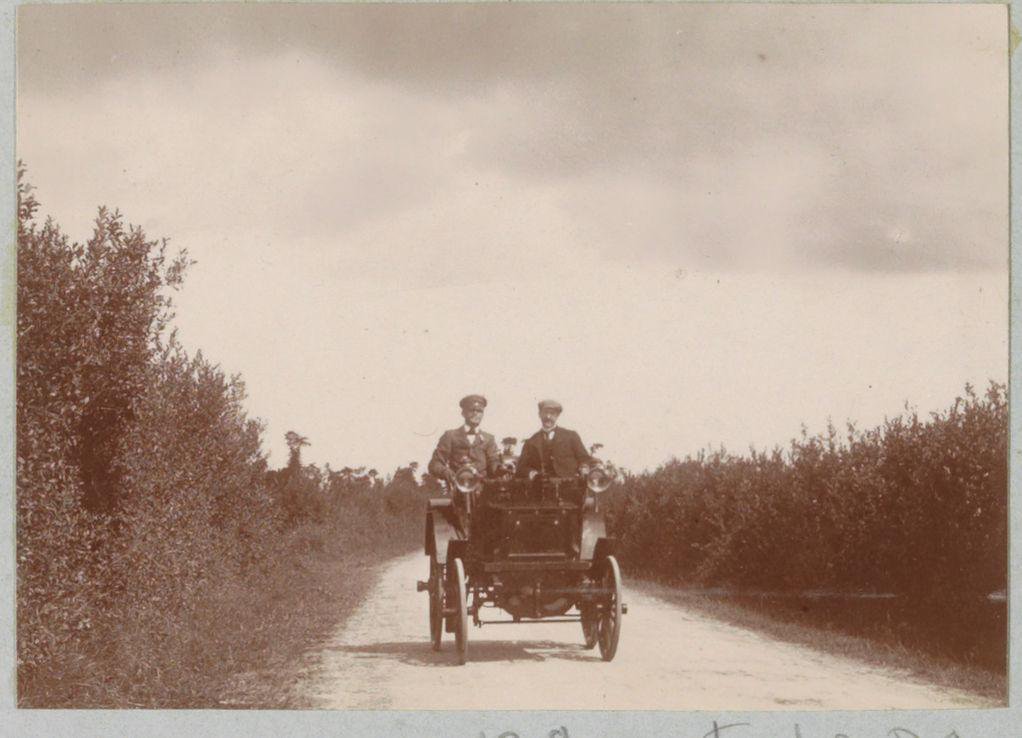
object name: photograph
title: Twee mannen in een automobiel op een landweg bij Varaville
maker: delizy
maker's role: manufacturer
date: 1808-1897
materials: paper, photographic support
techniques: gelatin silver print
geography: varaville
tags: road, path, automobile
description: Onderdeel van Fotoalbum van een Franse amateurfotograaf met opnames van uitstapjes in Frankrijk, Spanje, België, Luxemburg en Nederland, de eerste automobielen en autoraces.